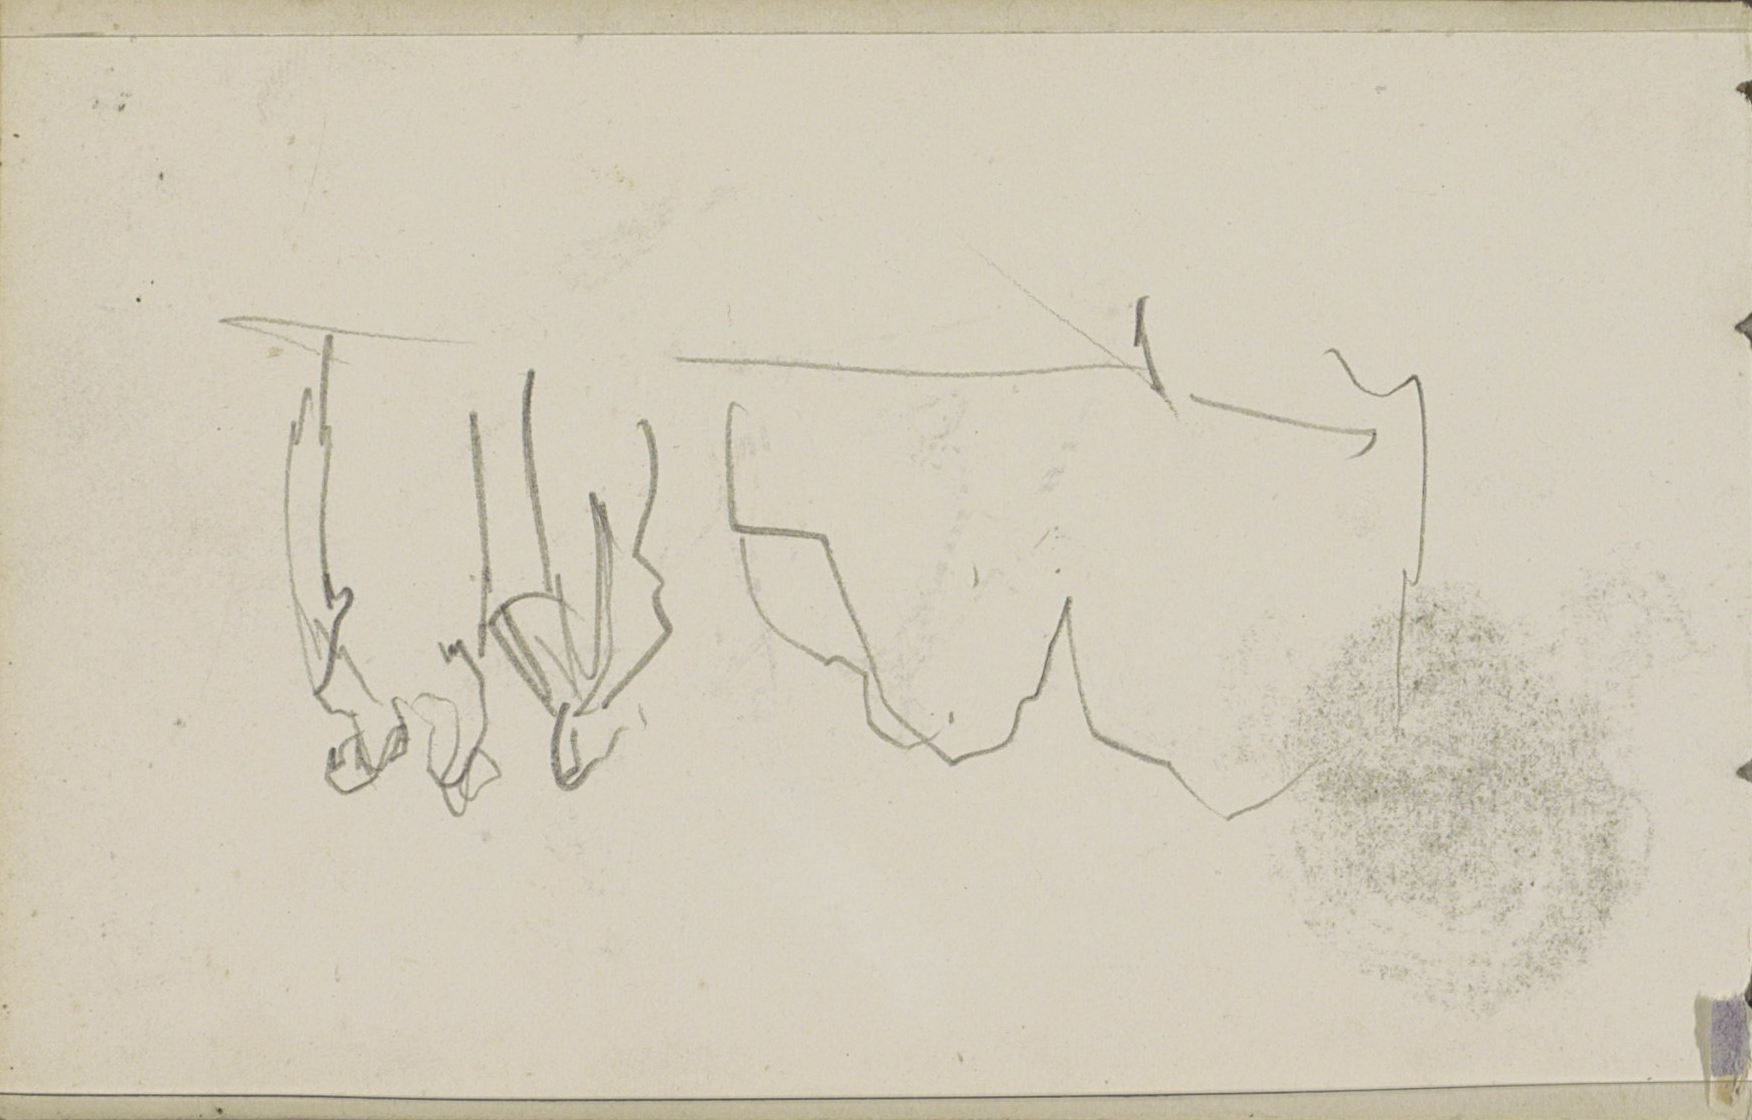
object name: sketchbook leaf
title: Figuren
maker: george clausen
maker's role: draughtsman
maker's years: 1852-1912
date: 1875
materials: paper, pencil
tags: anatomy (non-medical)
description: Blad 33 verso uit een schetsboek met 38 bladen.